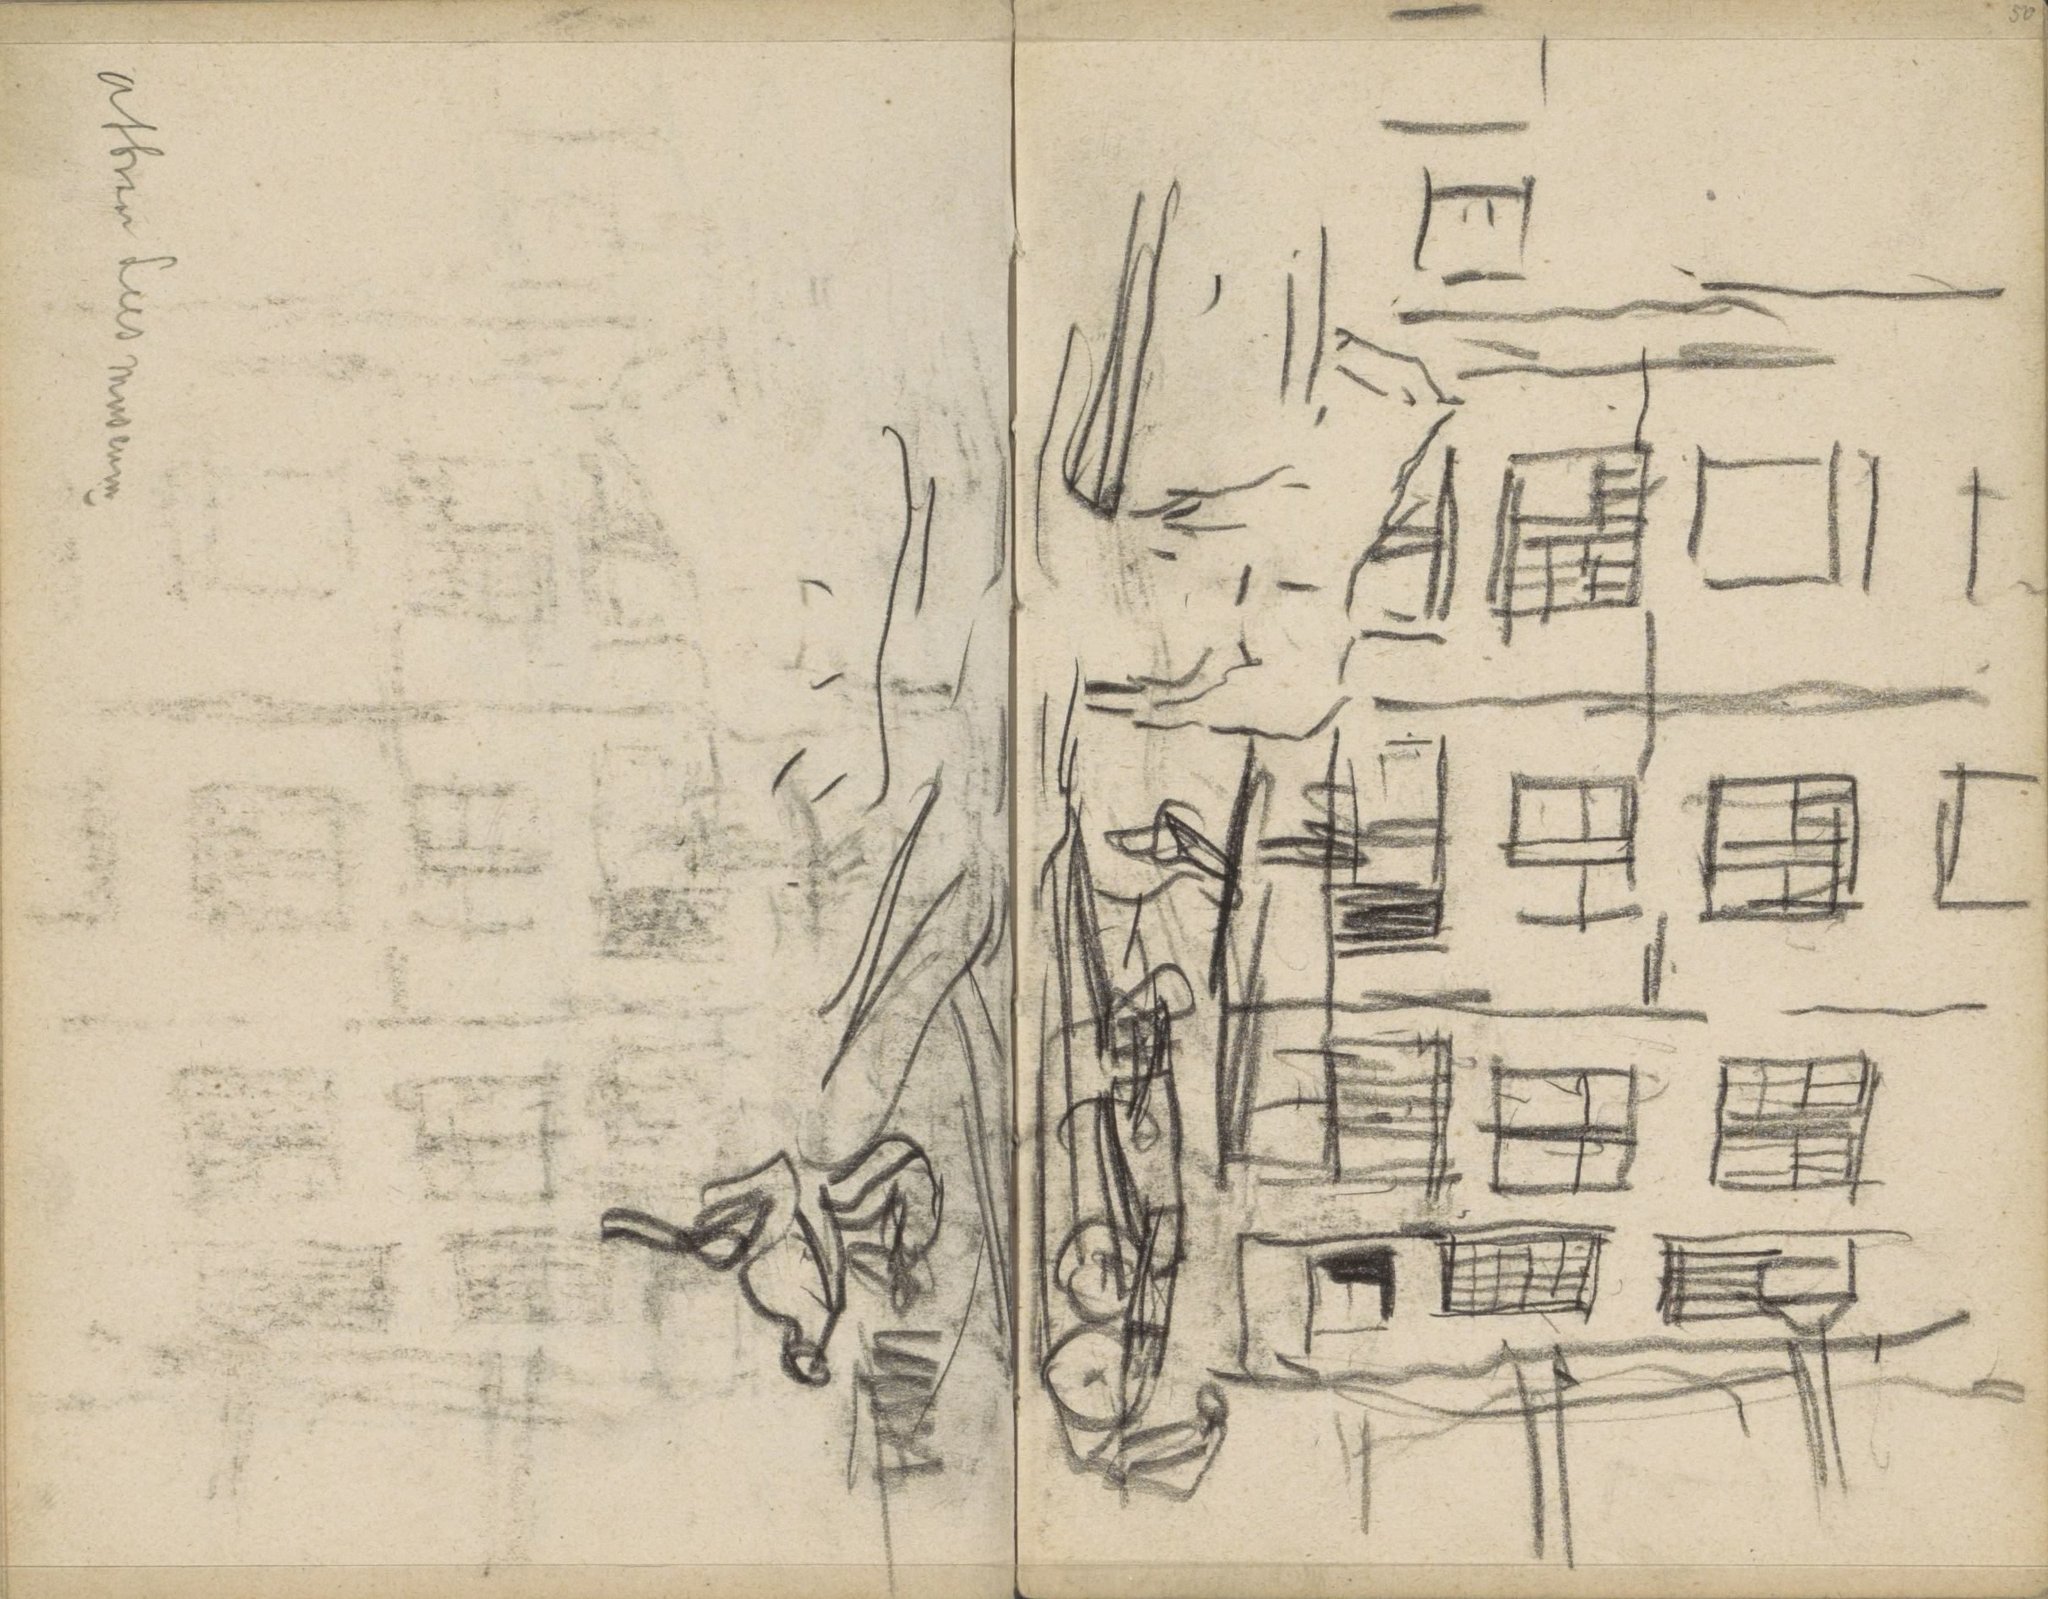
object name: sketchbook leaf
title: Gezicht op de sloop van het Leesmuseum aan het Rokin te Amsterdam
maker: george hendrik breitner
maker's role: draughtsman, painter, print maker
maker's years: 1857-1923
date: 1903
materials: chalk, paper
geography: amsterdam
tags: urban housing, demolition of building, horse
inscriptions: annotation: ‘afbraak Leesmuseum’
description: Gezicht op de sloop van het Leesmuseum aan het Rokin te Amsterdam. Pagina 49 en pagina 50 uit een schetsboek met 46 bladen.